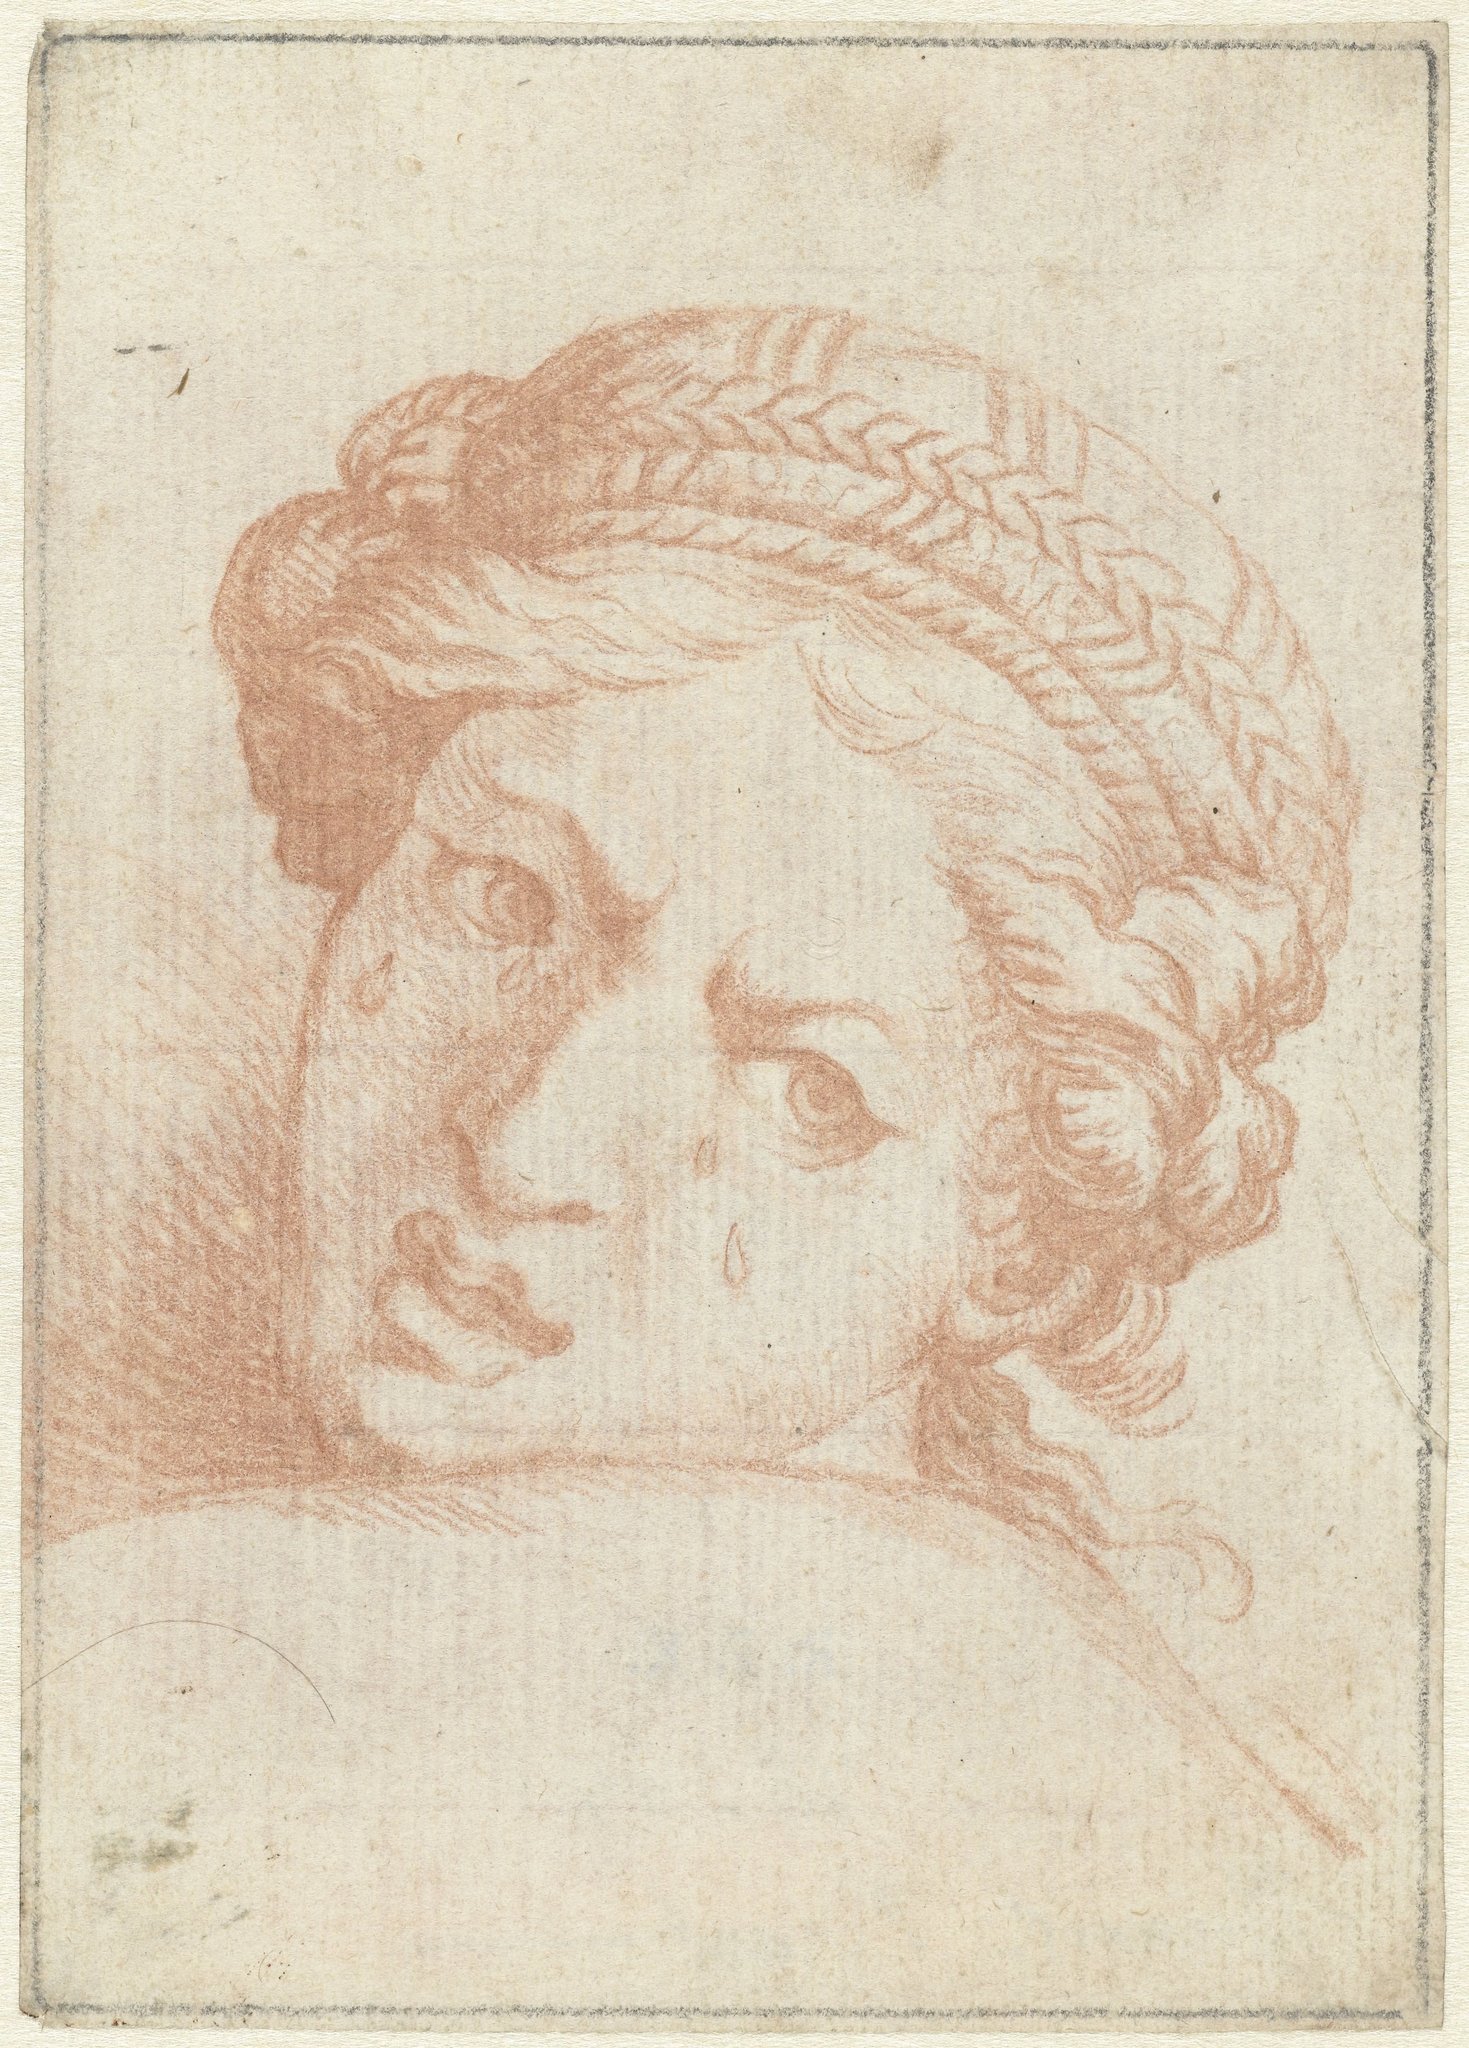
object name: drawing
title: Hoofd van een huilende vrouw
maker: bernard picart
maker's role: draughtsman, print maker, publisher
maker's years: 1673-1733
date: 1683-1733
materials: chalk, paper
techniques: printmaking